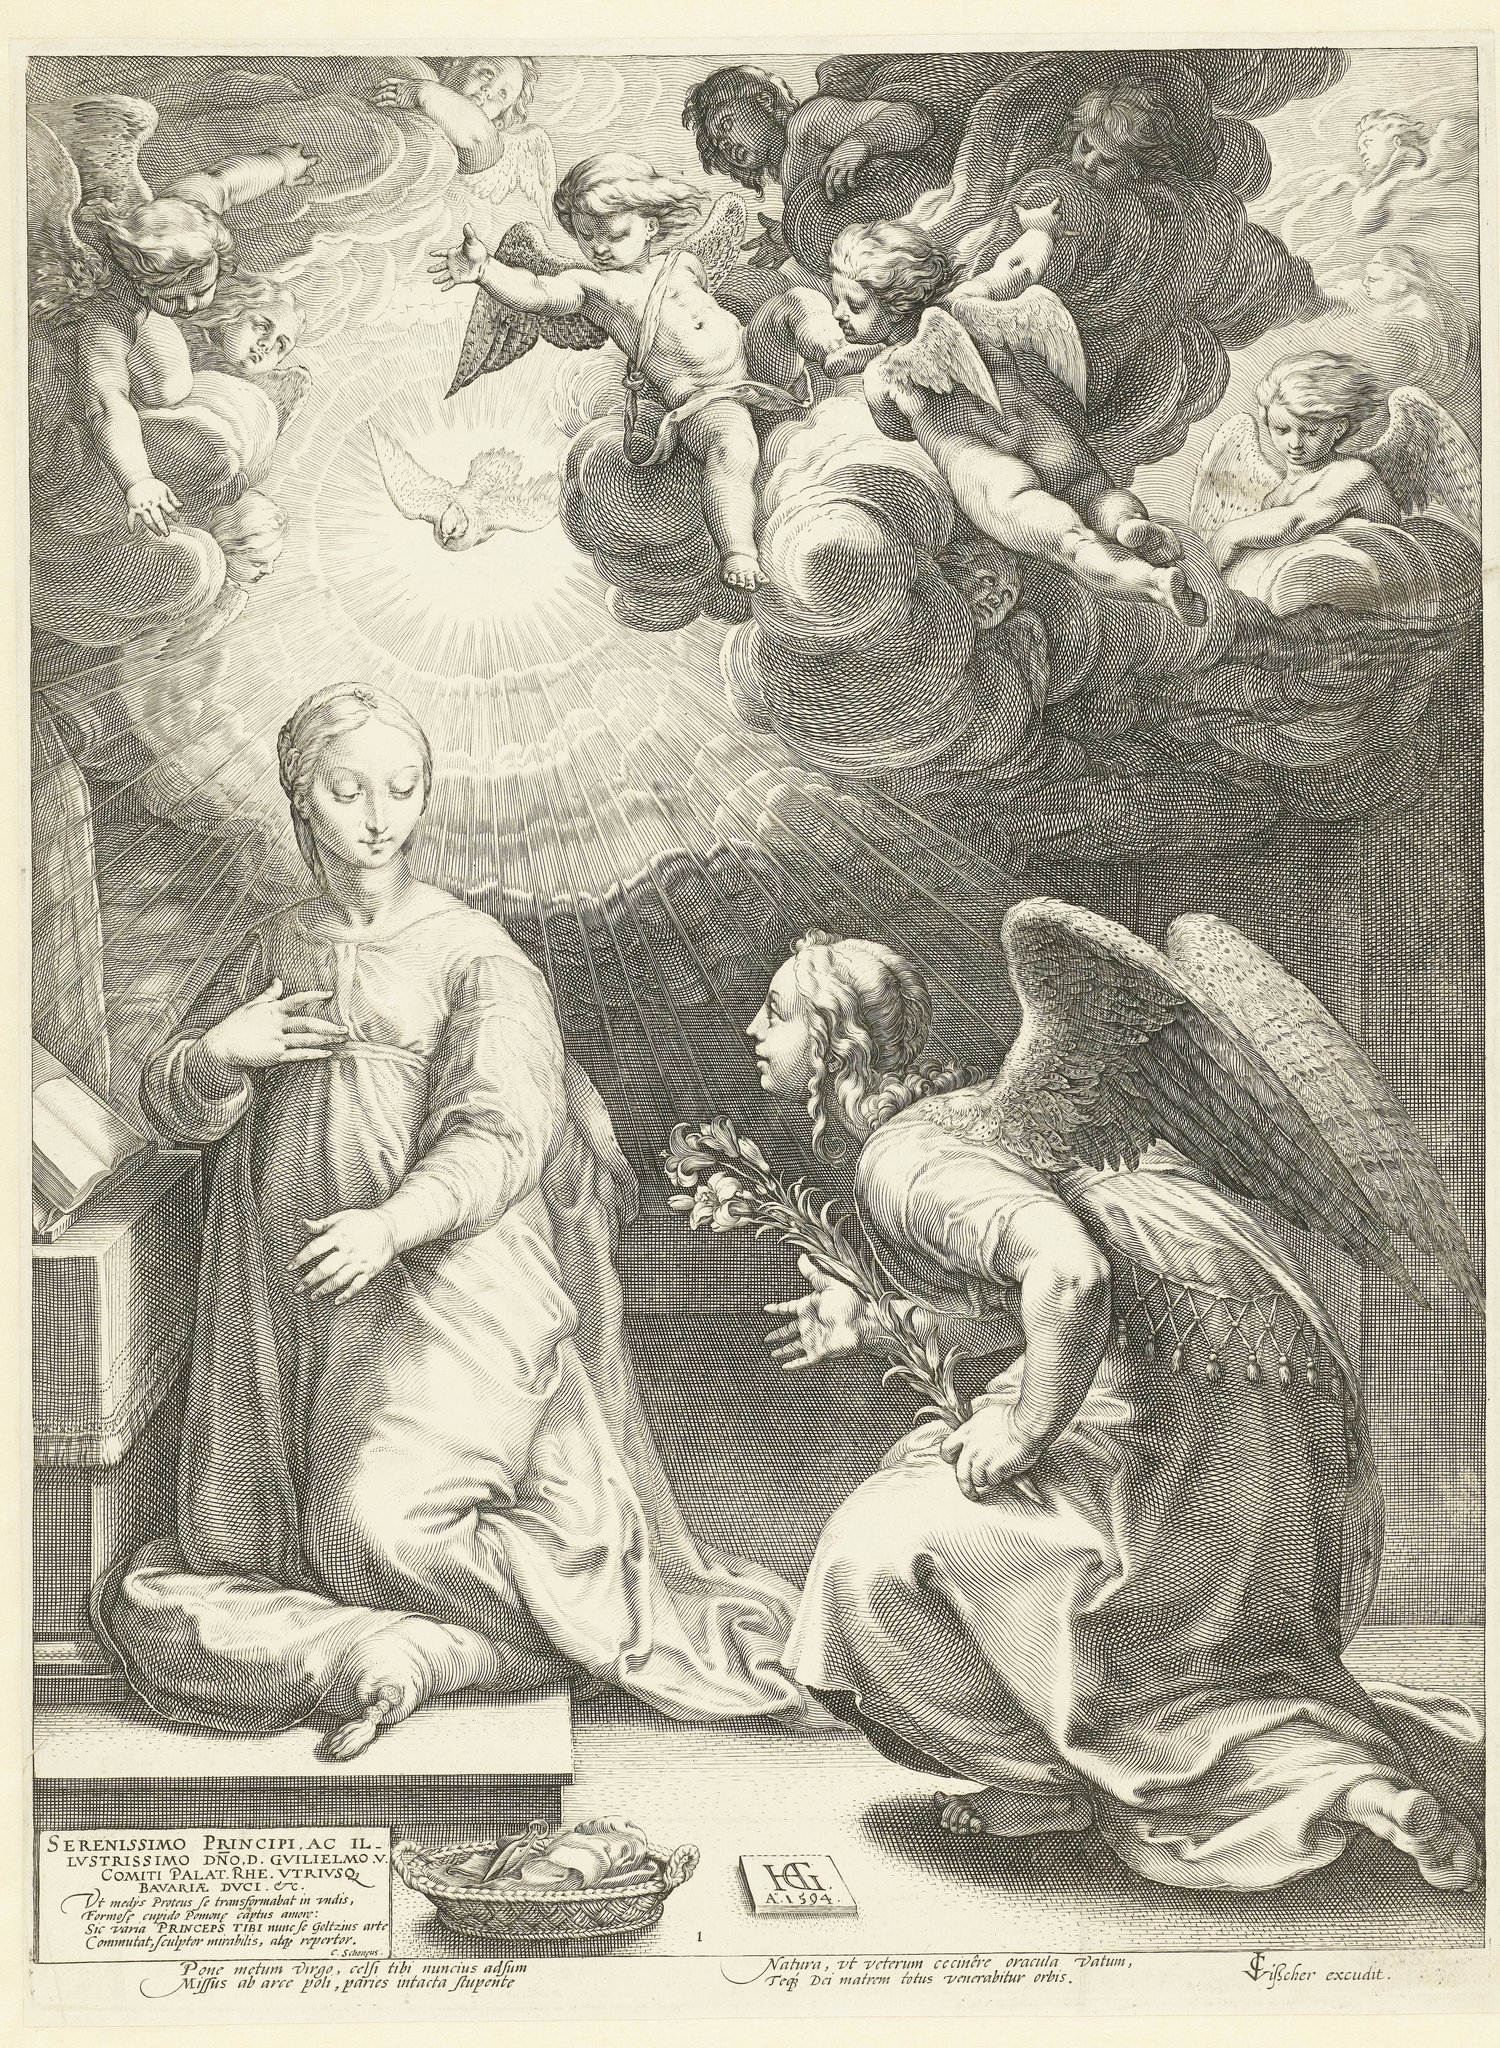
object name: print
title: De annunciatie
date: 1594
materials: paper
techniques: engraving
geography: amsterdam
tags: the annunciation: mary kneeling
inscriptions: collector's mark: Lugt 2228a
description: De engel Gabriël kondigt de geboorte van Christus aan bij Maria, die op de knieën bij een lezenaar zit. Vanuit de hemel daalt een duif neer, omgeven door engelen. Links onderin de voorstelling een opdracht in het Latijn; onder de voorstelling vier Latijnse versregels. Deze prent is onderdeel van een serie van zes prenten met scènes uit het vroege leven van Maria. Die worden de 'Meesterstukken' genoemd, omdat Goltzius er het werk van verschillende illustere voorgangers in heeft nagebootst.